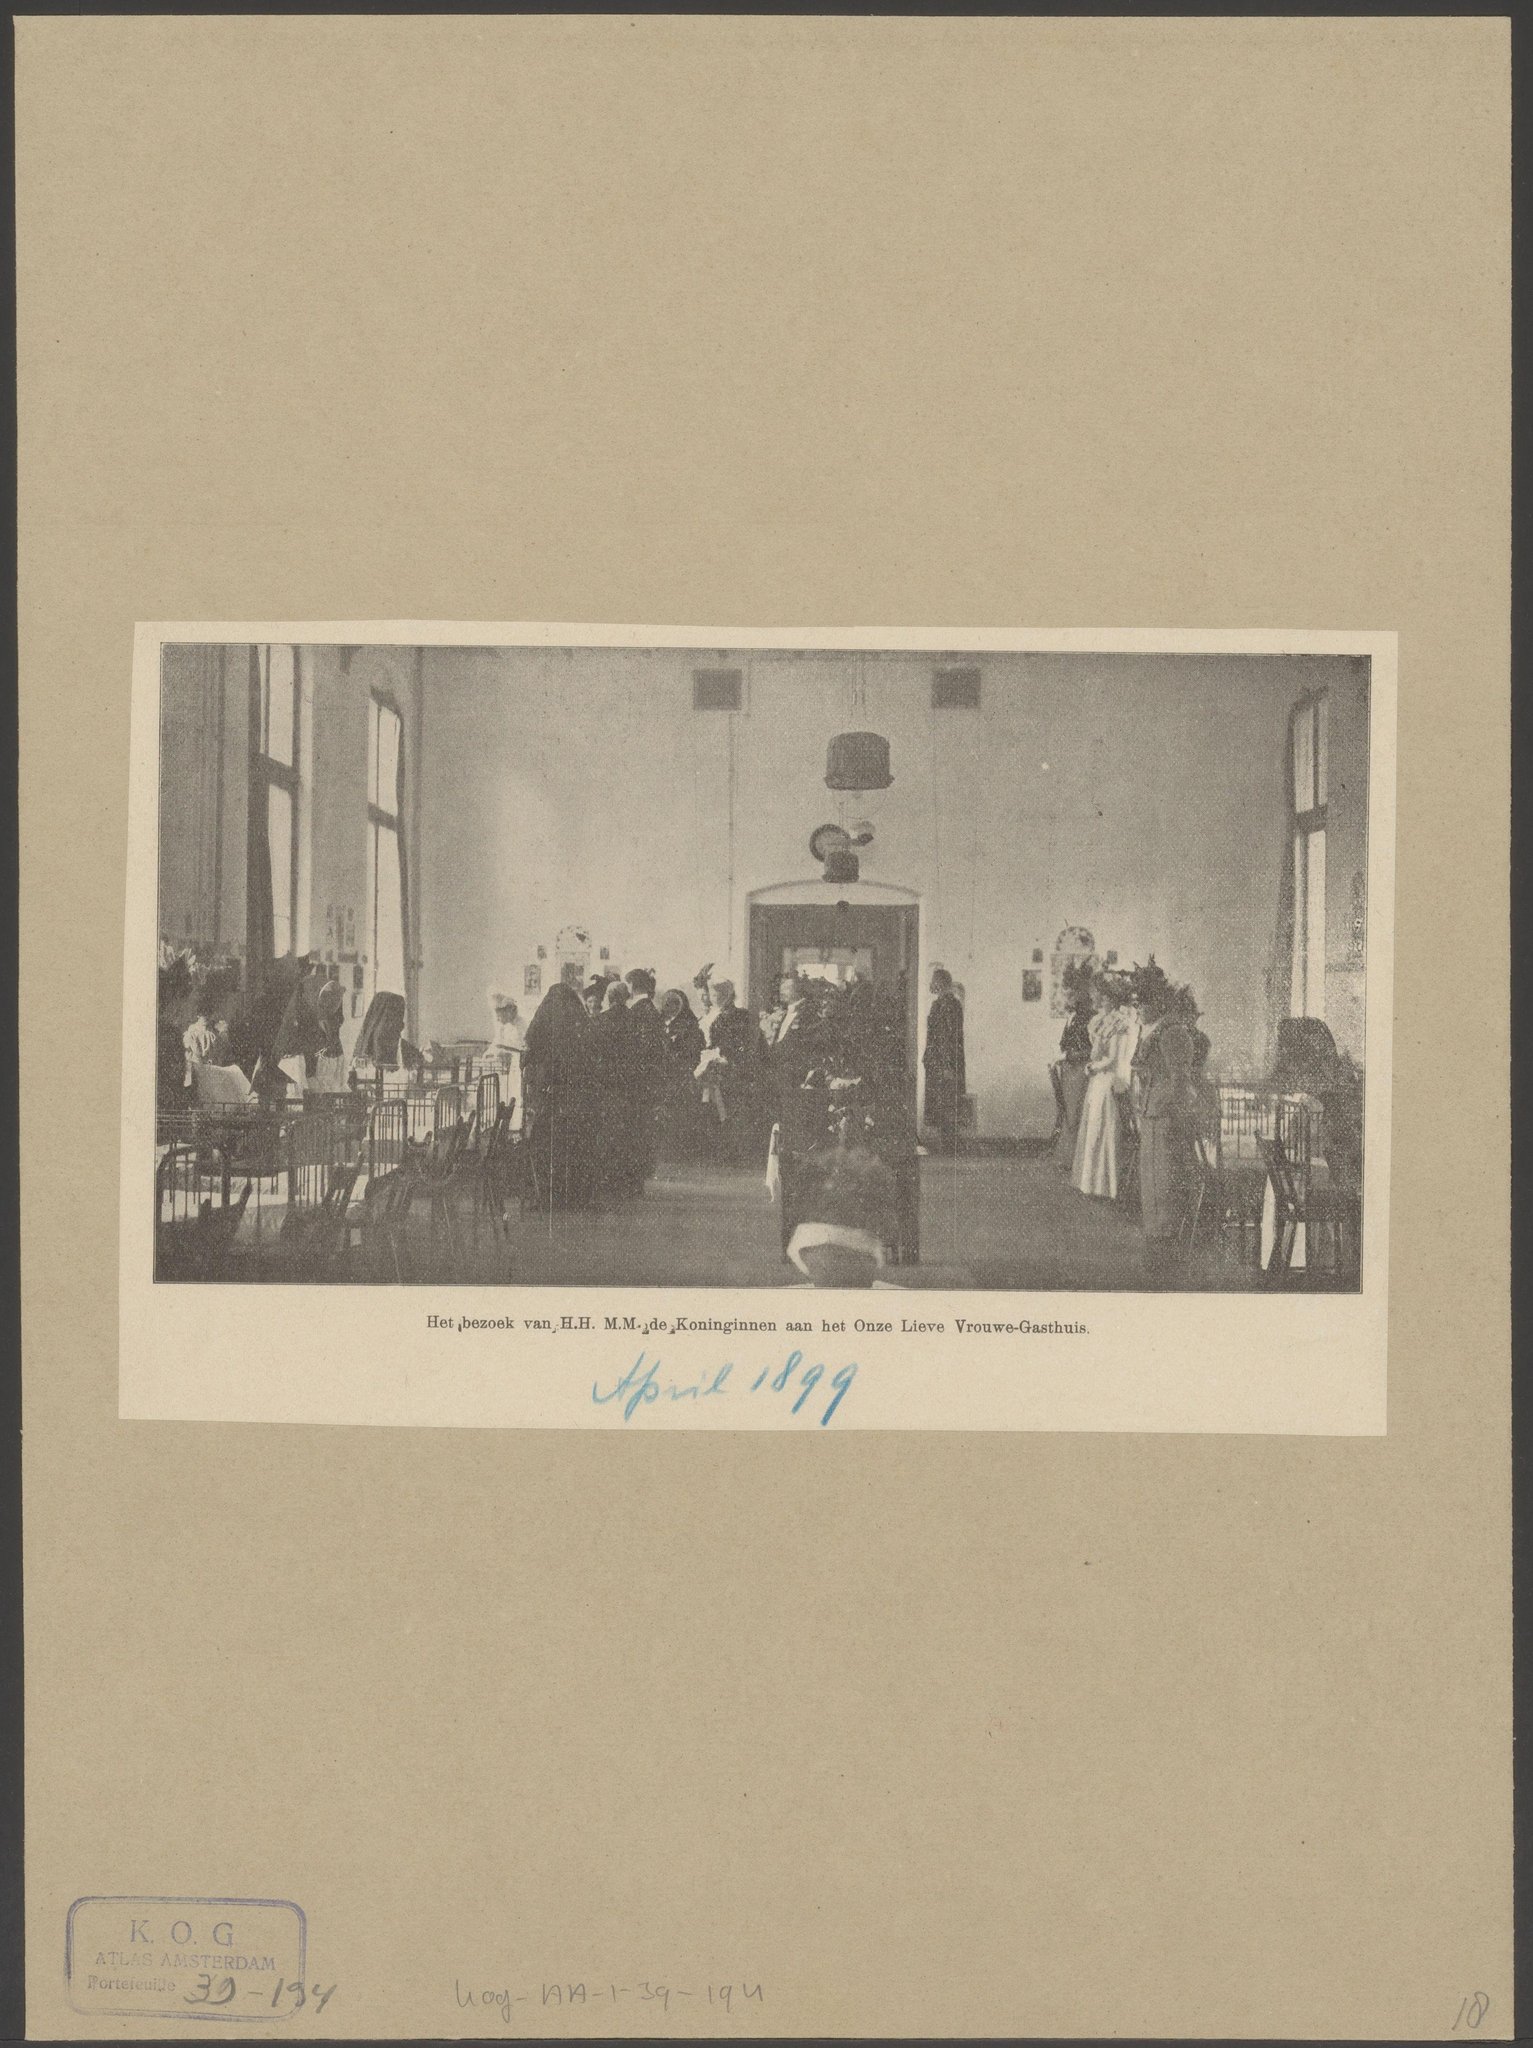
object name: photomechanical print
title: Het bezoek van H.H. M.M. de Koninginnen aan het Onze Lieve Vrouwe-Gasthuis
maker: Anonymous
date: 1804-1899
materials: paper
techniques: letterpress printing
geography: netherlands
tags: the hague, print maker, wilhelmina of the netherlands, emma (queen consort of the netherlands), hospital, cradle, crib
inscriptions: collector's mark: Lugt 1641b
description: Onderwerpsrubriek binnen de Atlas Amsterdam: Armwezen en liefdadige instellingen: V. Ziekenhuizen: O.L. Vrouwe Gasthuis.